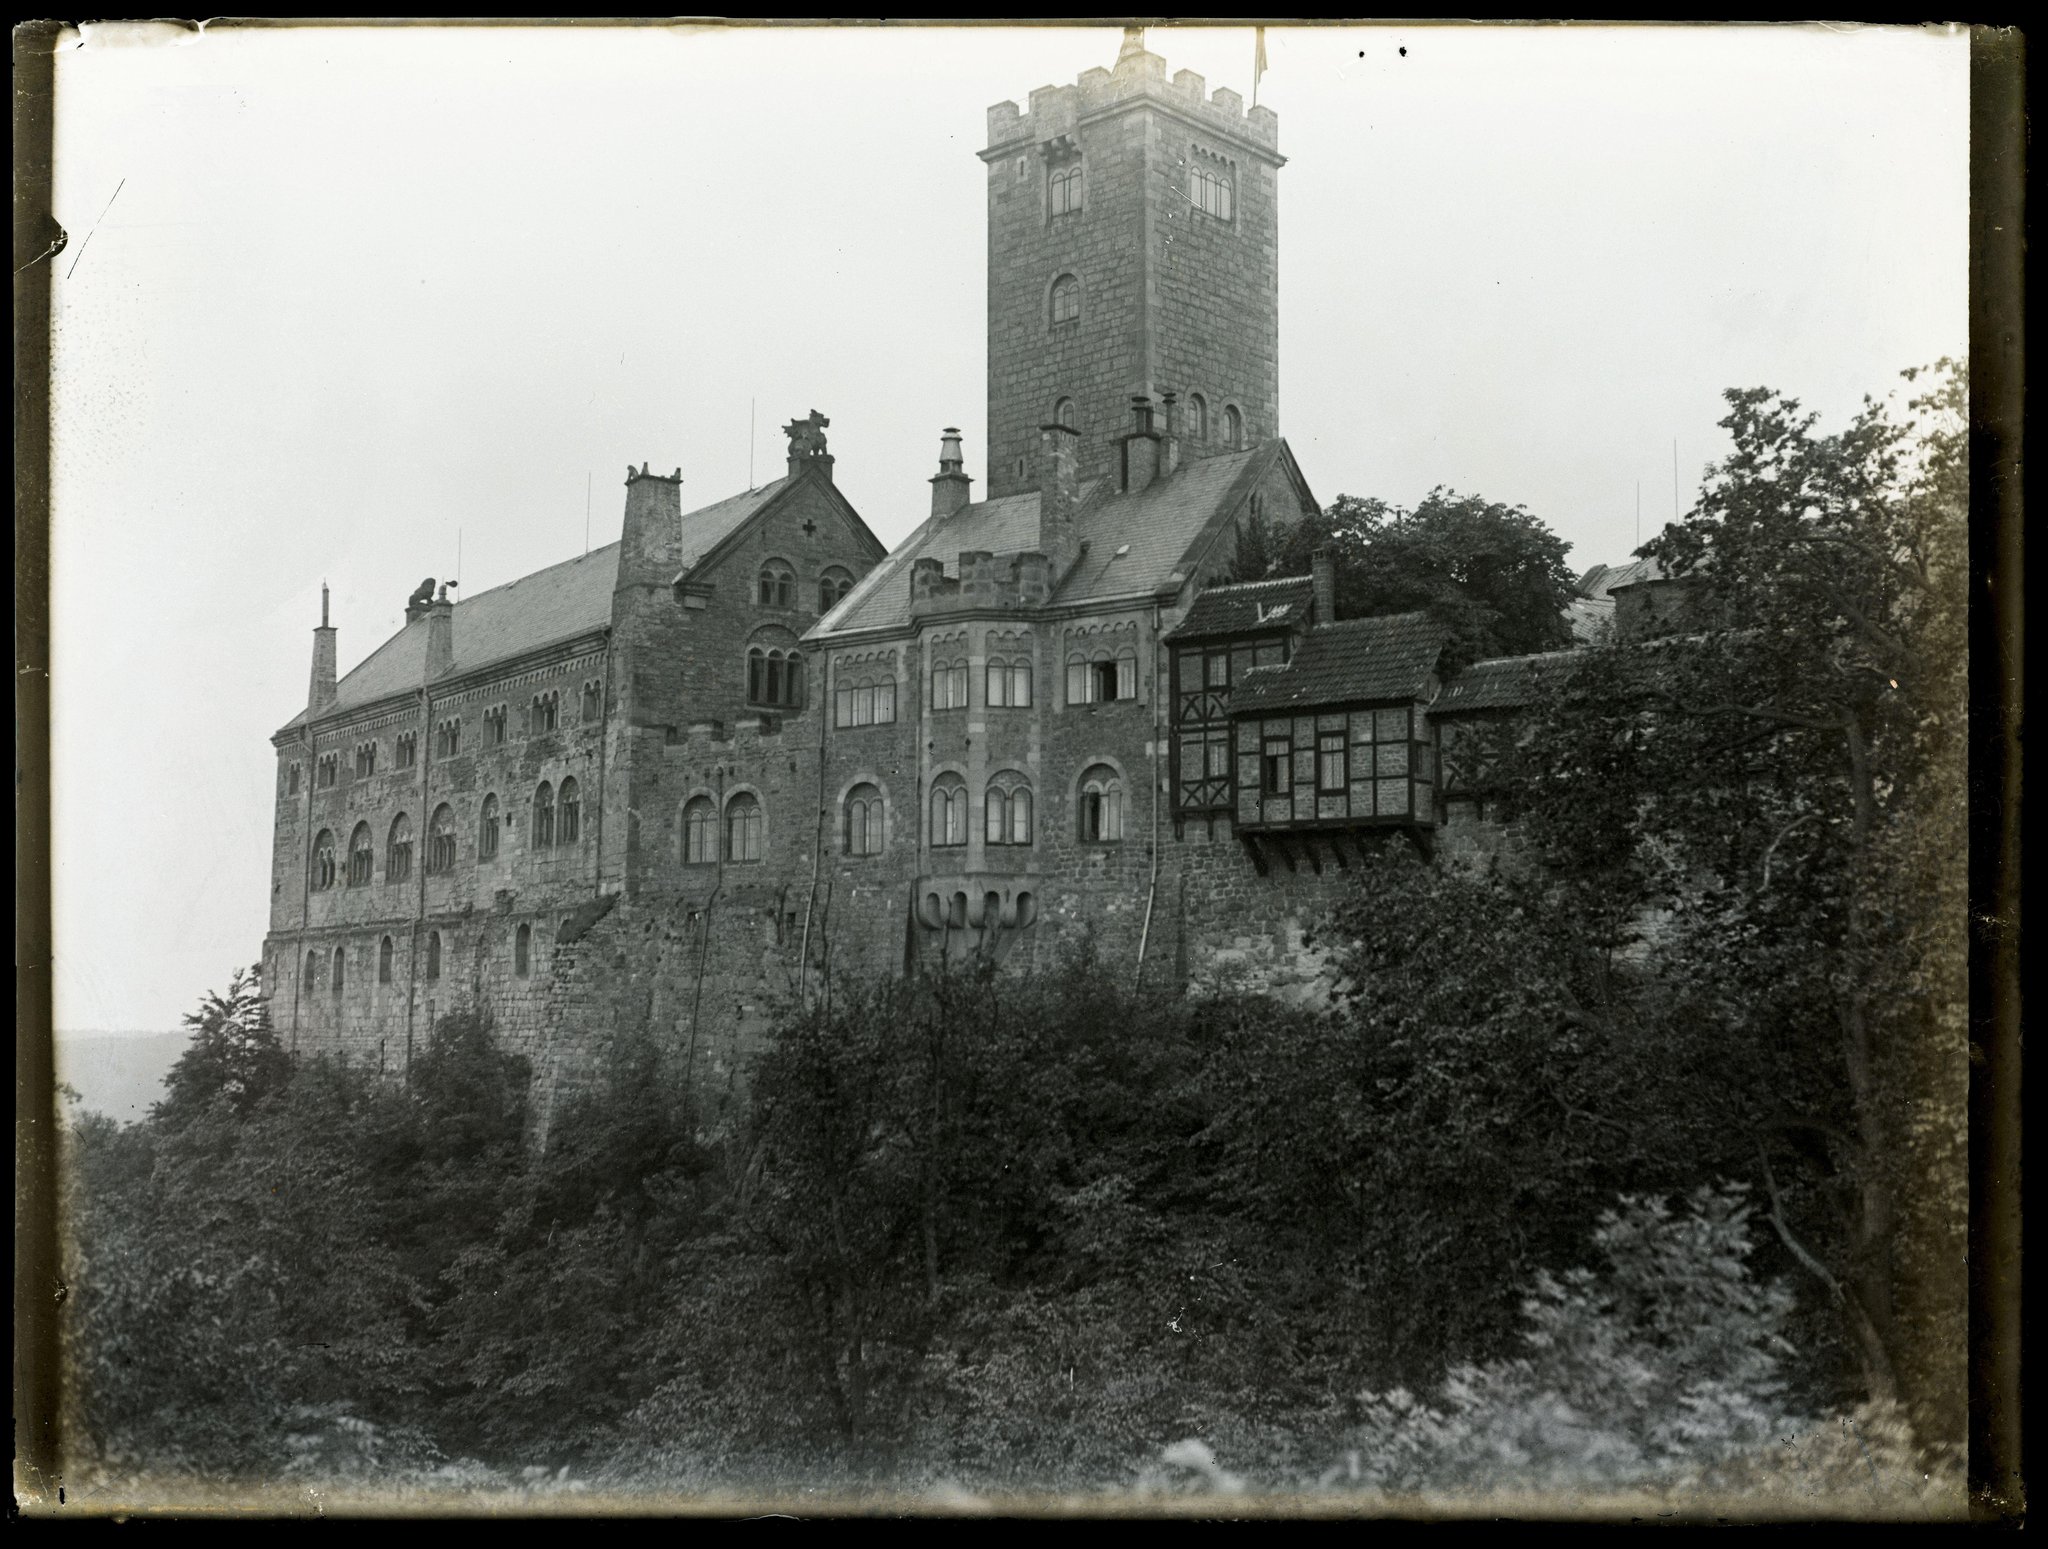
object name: glasnegatief, glasplaatnegatief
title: Kasteel Wartburg te Eisenach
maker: Anonymous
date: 1907-1935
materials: glass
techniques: gelatin glass negative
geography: eisenach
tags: castle